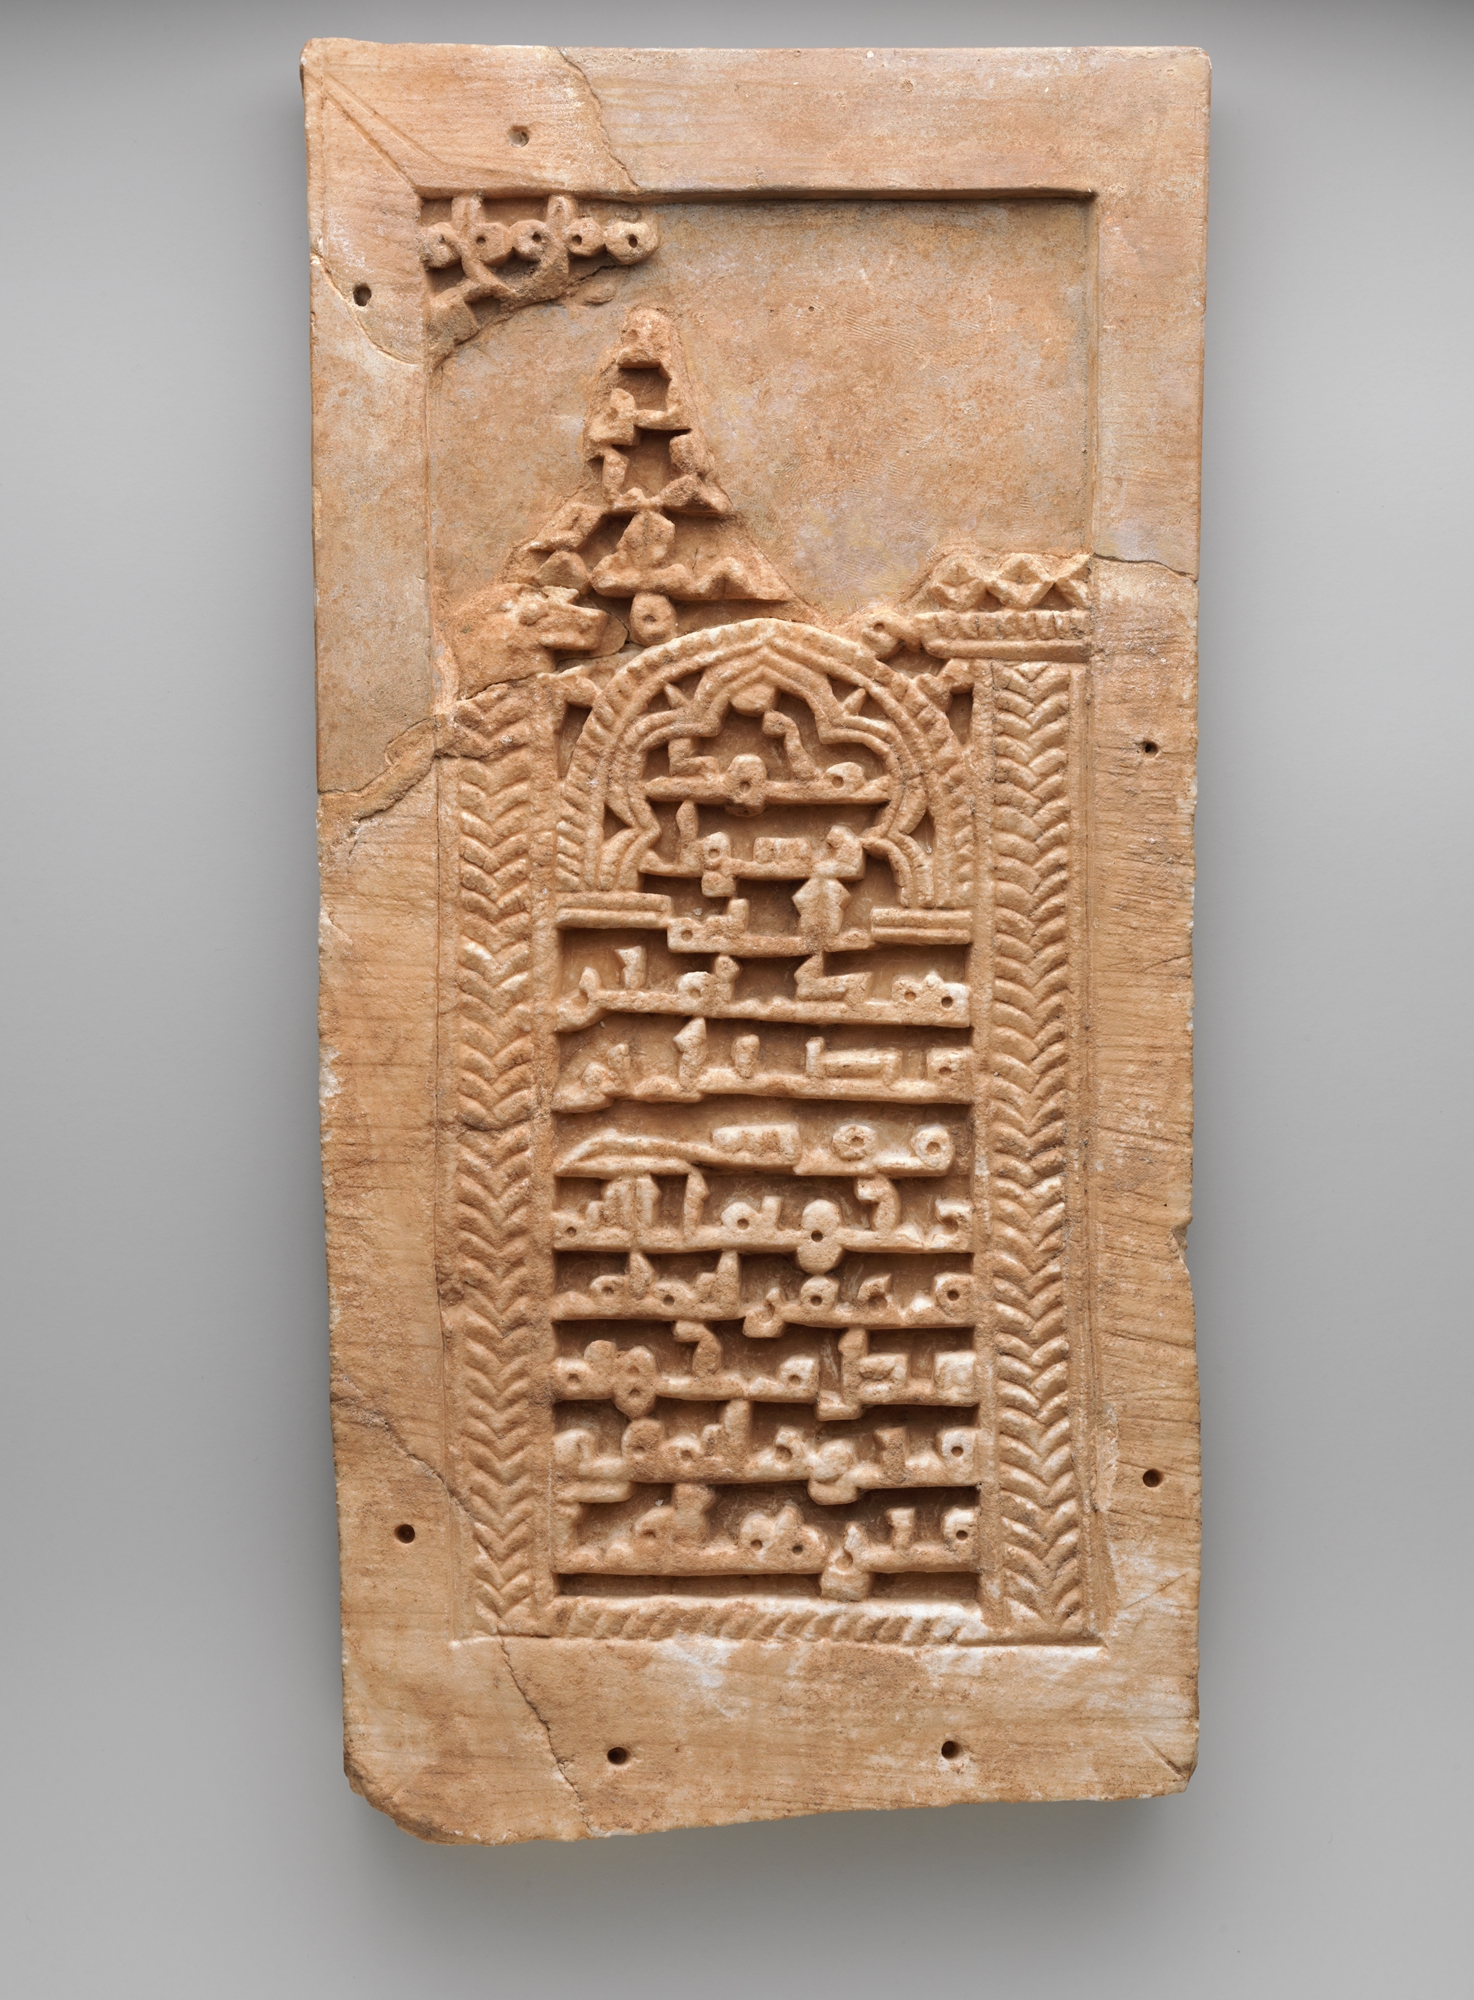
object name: stele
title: Gravestone of Fudayl ibn Musa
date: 901-1100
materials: alabaster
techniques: carving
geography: iran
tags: arabic